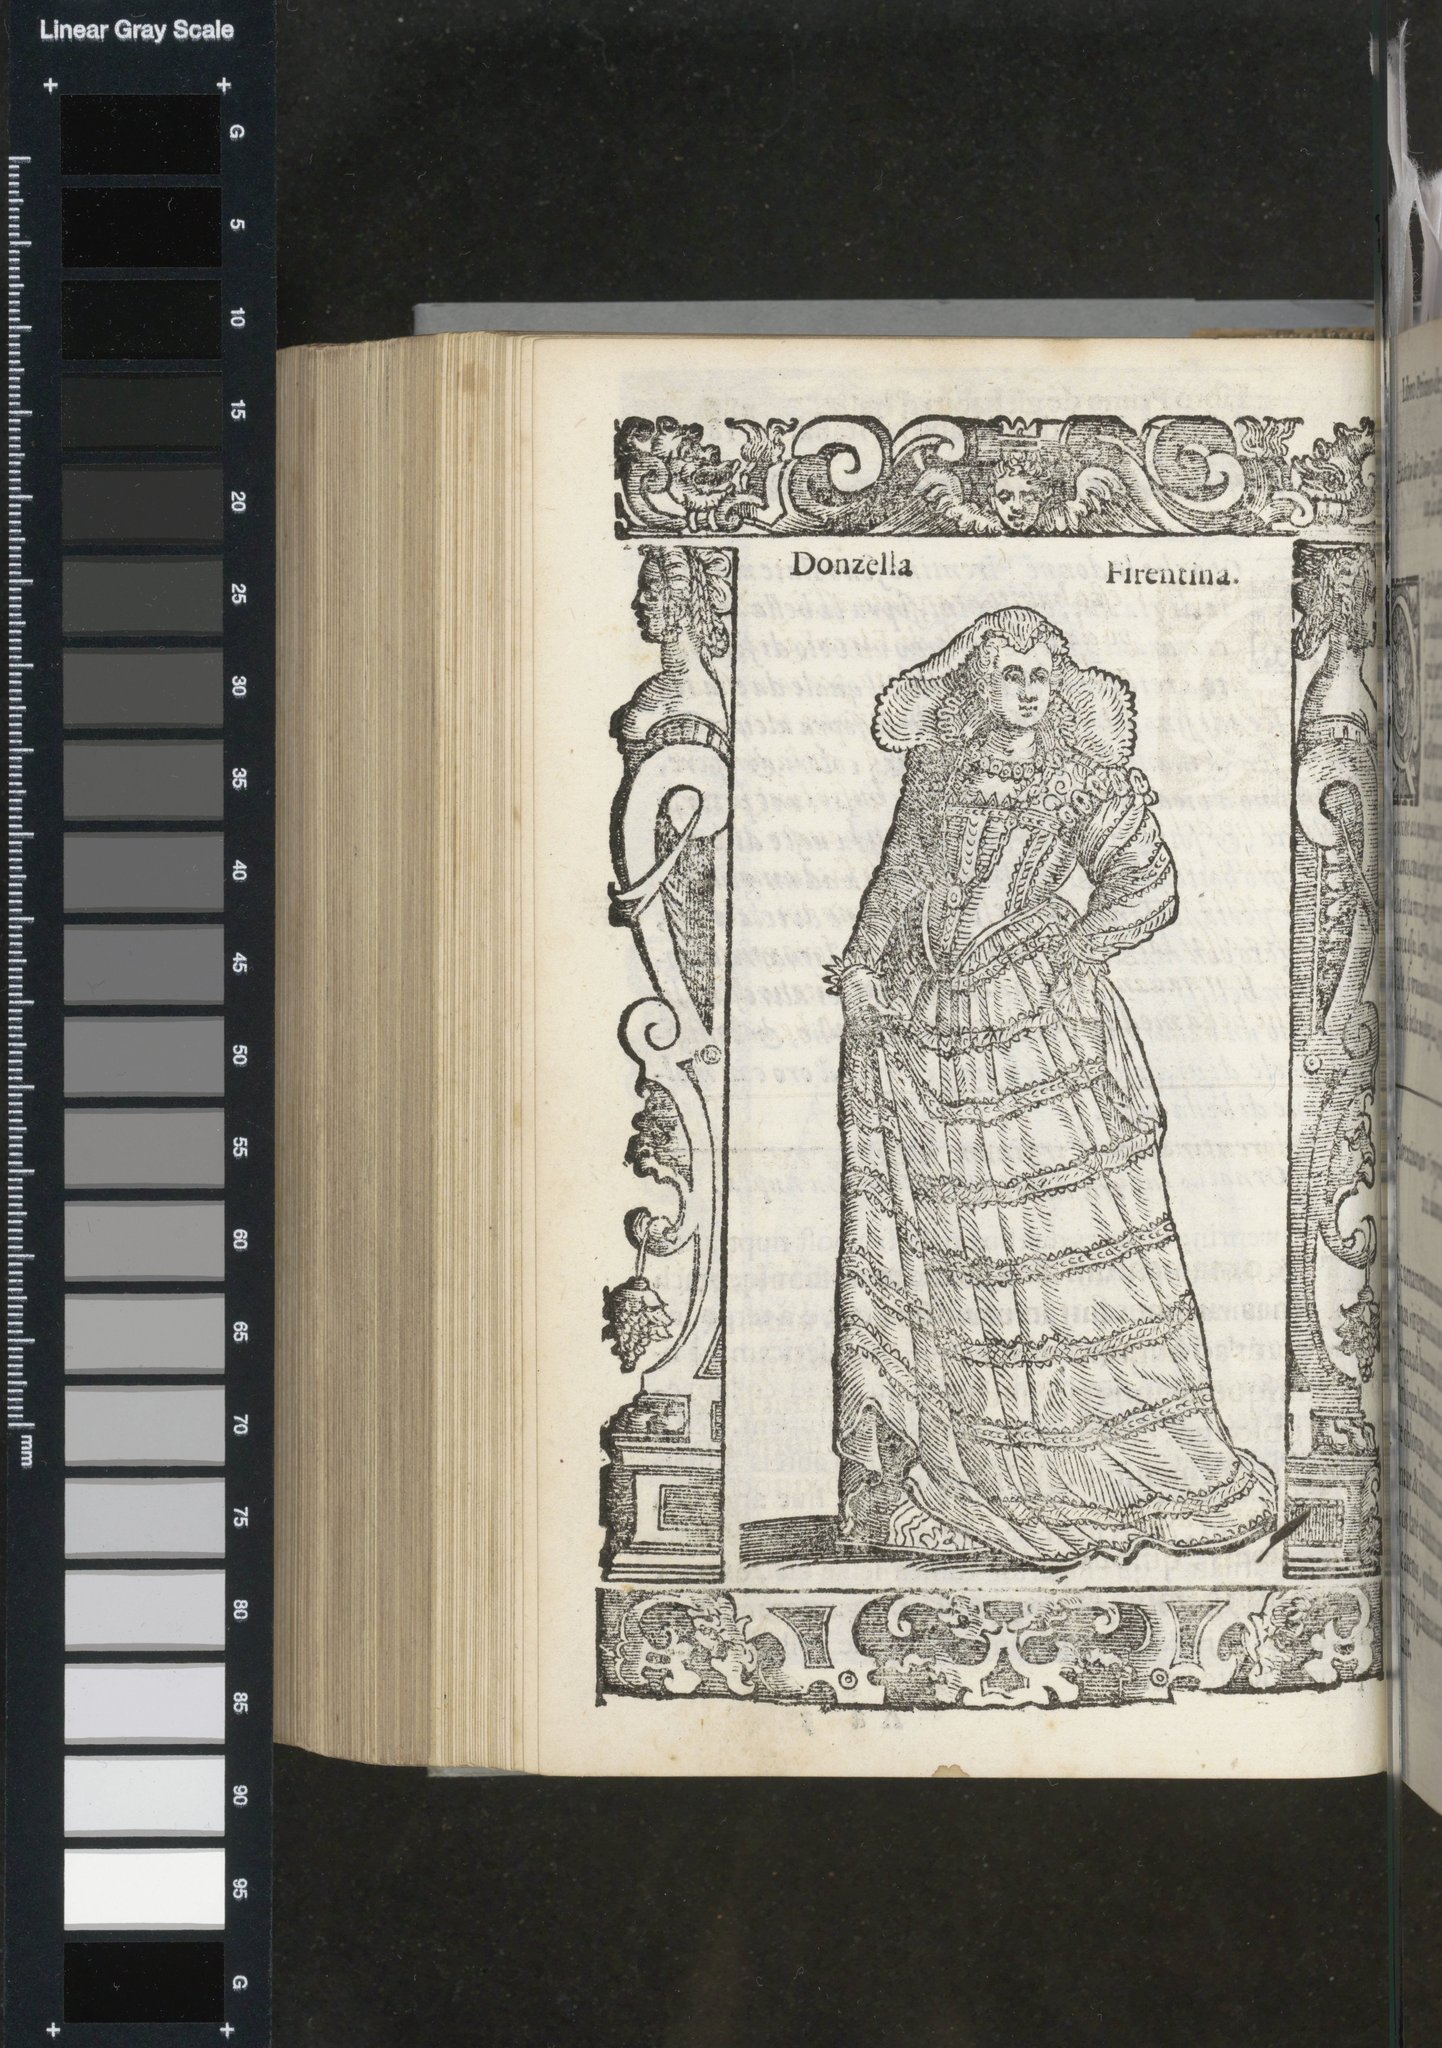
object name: costume print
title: Habiti antichi, et moderni di tutto il mondo...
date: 1598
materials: paper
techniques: woodcut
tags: pendant, trinket, 'breloque' (+ women's clothes), veil (+ women's clothes), neck-gear: collar (+ women's clothes), fashion plates, dress, gown (+ women's clothes), clothing for the upper part of the body (with name) (+ women's clothes)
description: Adellijke jongedame uit Florence, gekleed in een rok met horizontale banen, die tot op de grond valt, met een lang, puntig lijfje. Kraag (bavero) met kant. Brede sluier van zijde. Gouden keten met hanger. (eigenlijke titel: 'Nobile Firentina”)